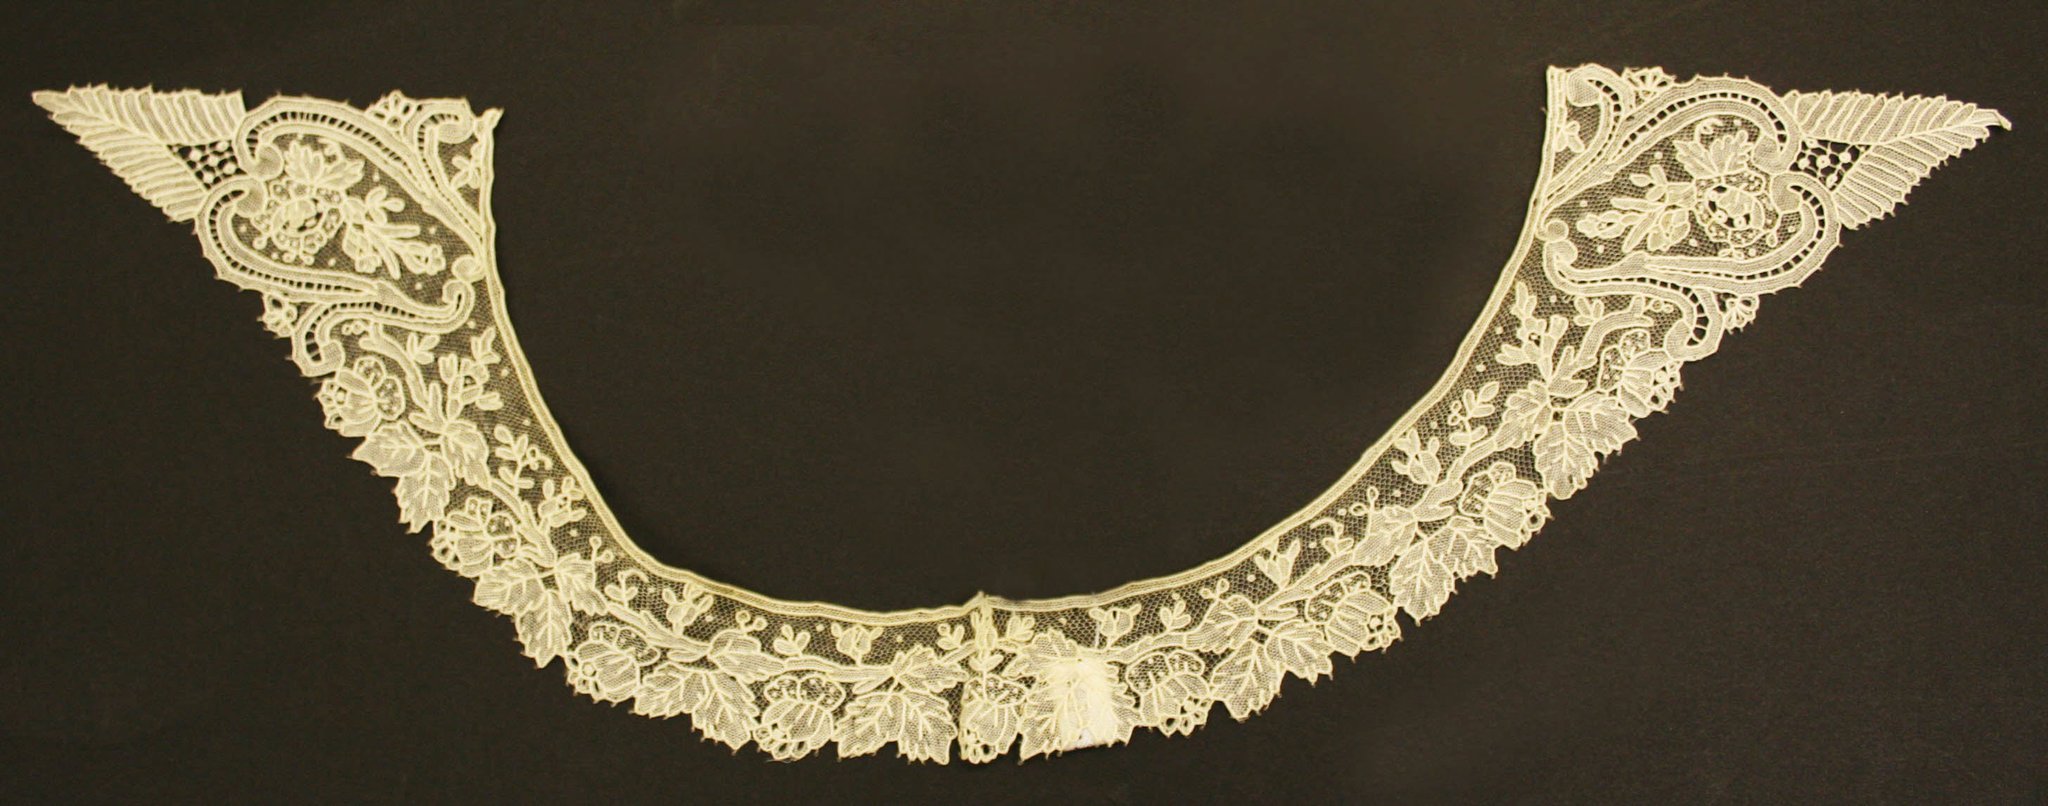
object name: collar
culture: european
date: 1861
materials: cotton